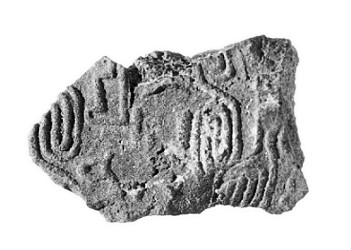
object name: sealing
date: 1981-1640 BCE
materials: mud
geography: egypt